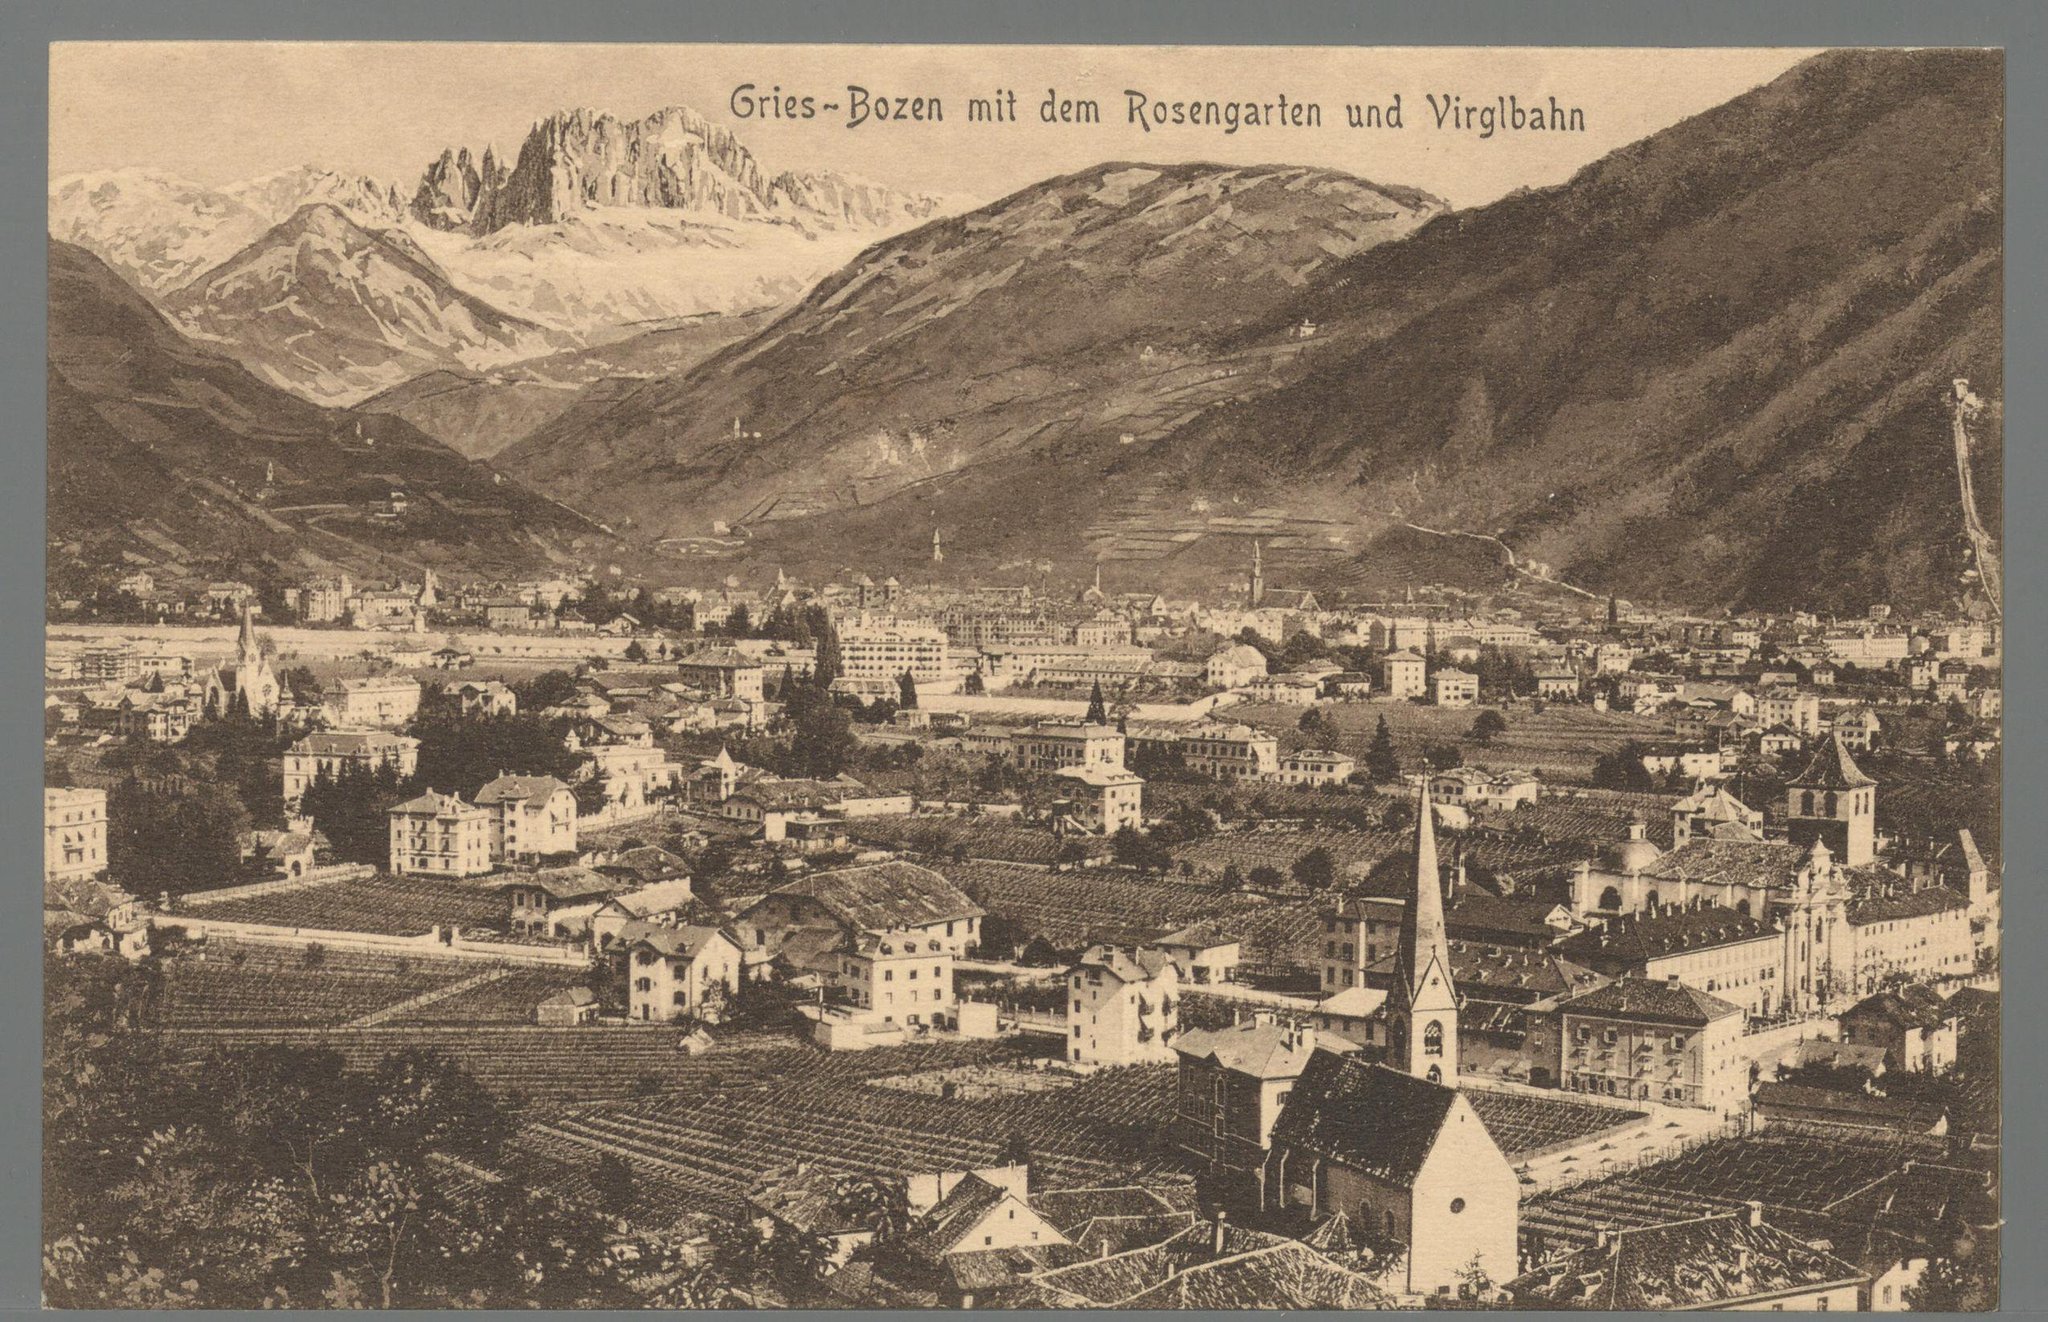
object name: ansichtkaart, prentbriefkaart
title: Gries-Bozen mit dem Rosengarten und Virglbahn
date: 1910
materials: cardboard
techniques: photograph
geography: bolzano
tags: prospect of city, town panorama, silhouette of city, mountains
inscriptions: date